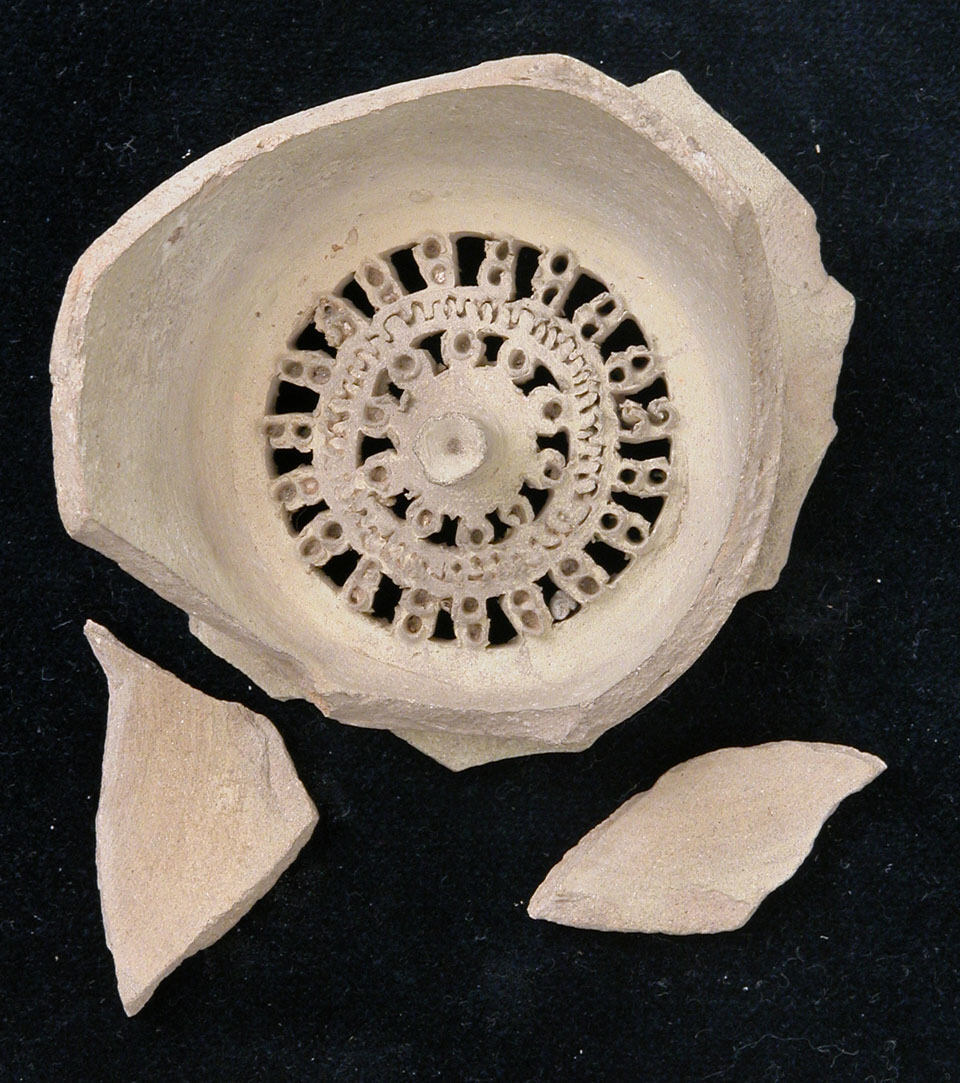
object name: water filter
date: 901-1200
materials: earthenware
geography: egypt